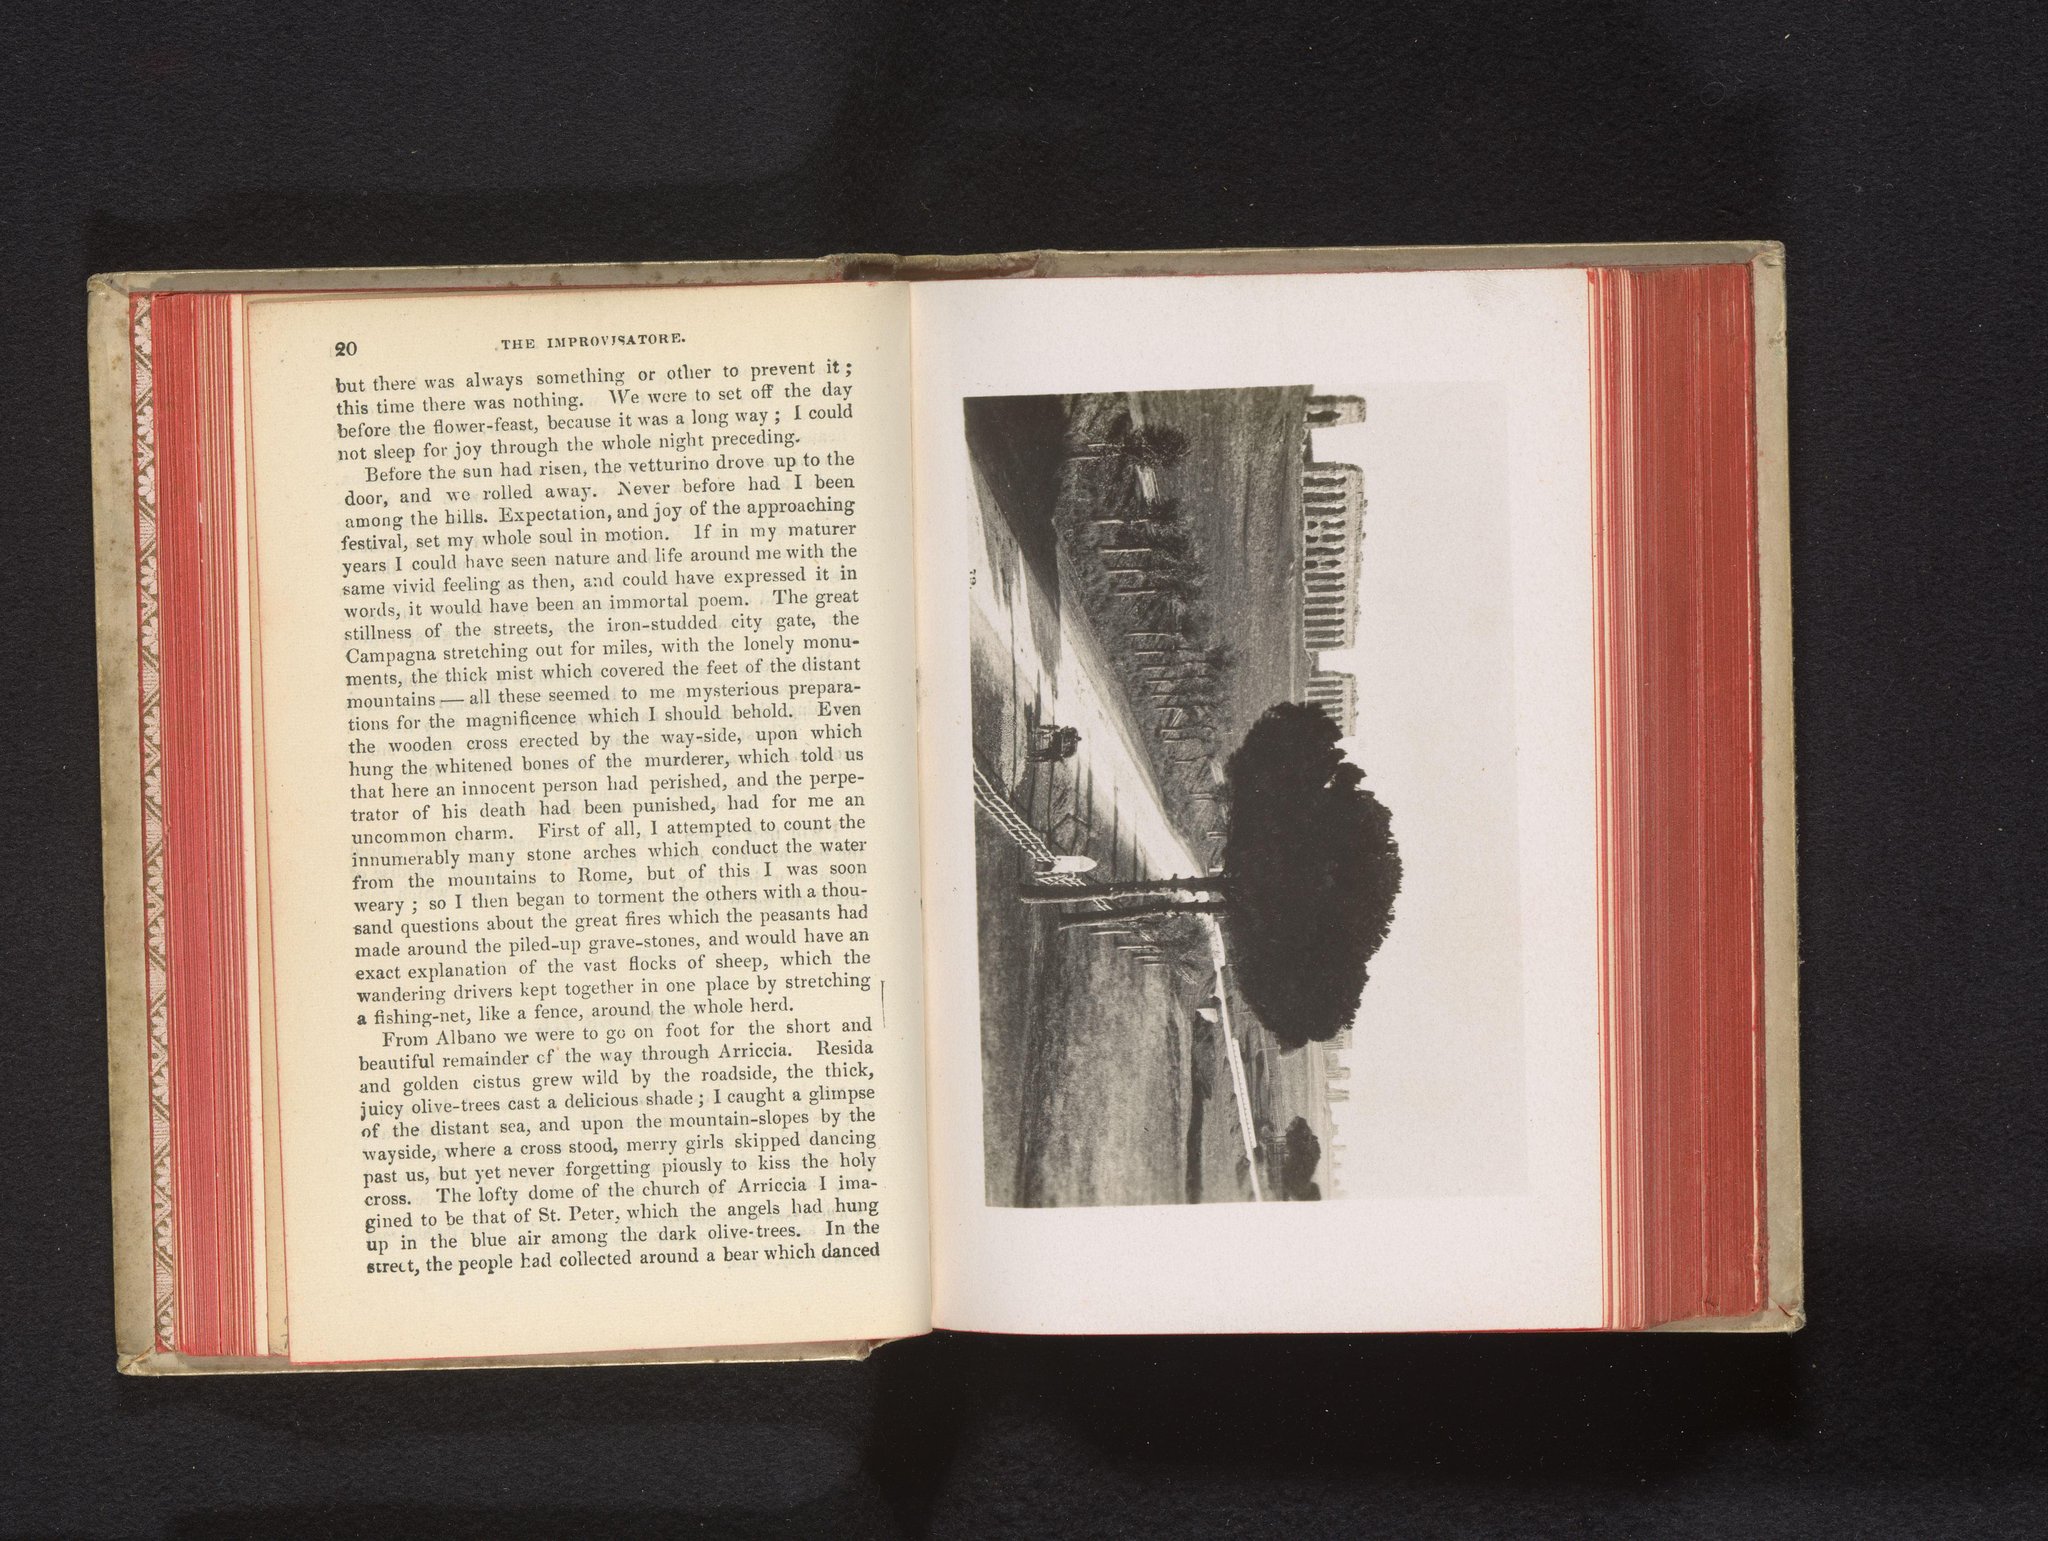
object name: page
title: Ruïne van de Aqua Claudia langs de Via Appia Antica nabij Rome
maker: Anonymous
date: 1870-1880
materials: photographic support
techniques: gelatin silver print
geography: via appia antica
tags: landscape with bridge, viaduct or aqueduct, public road